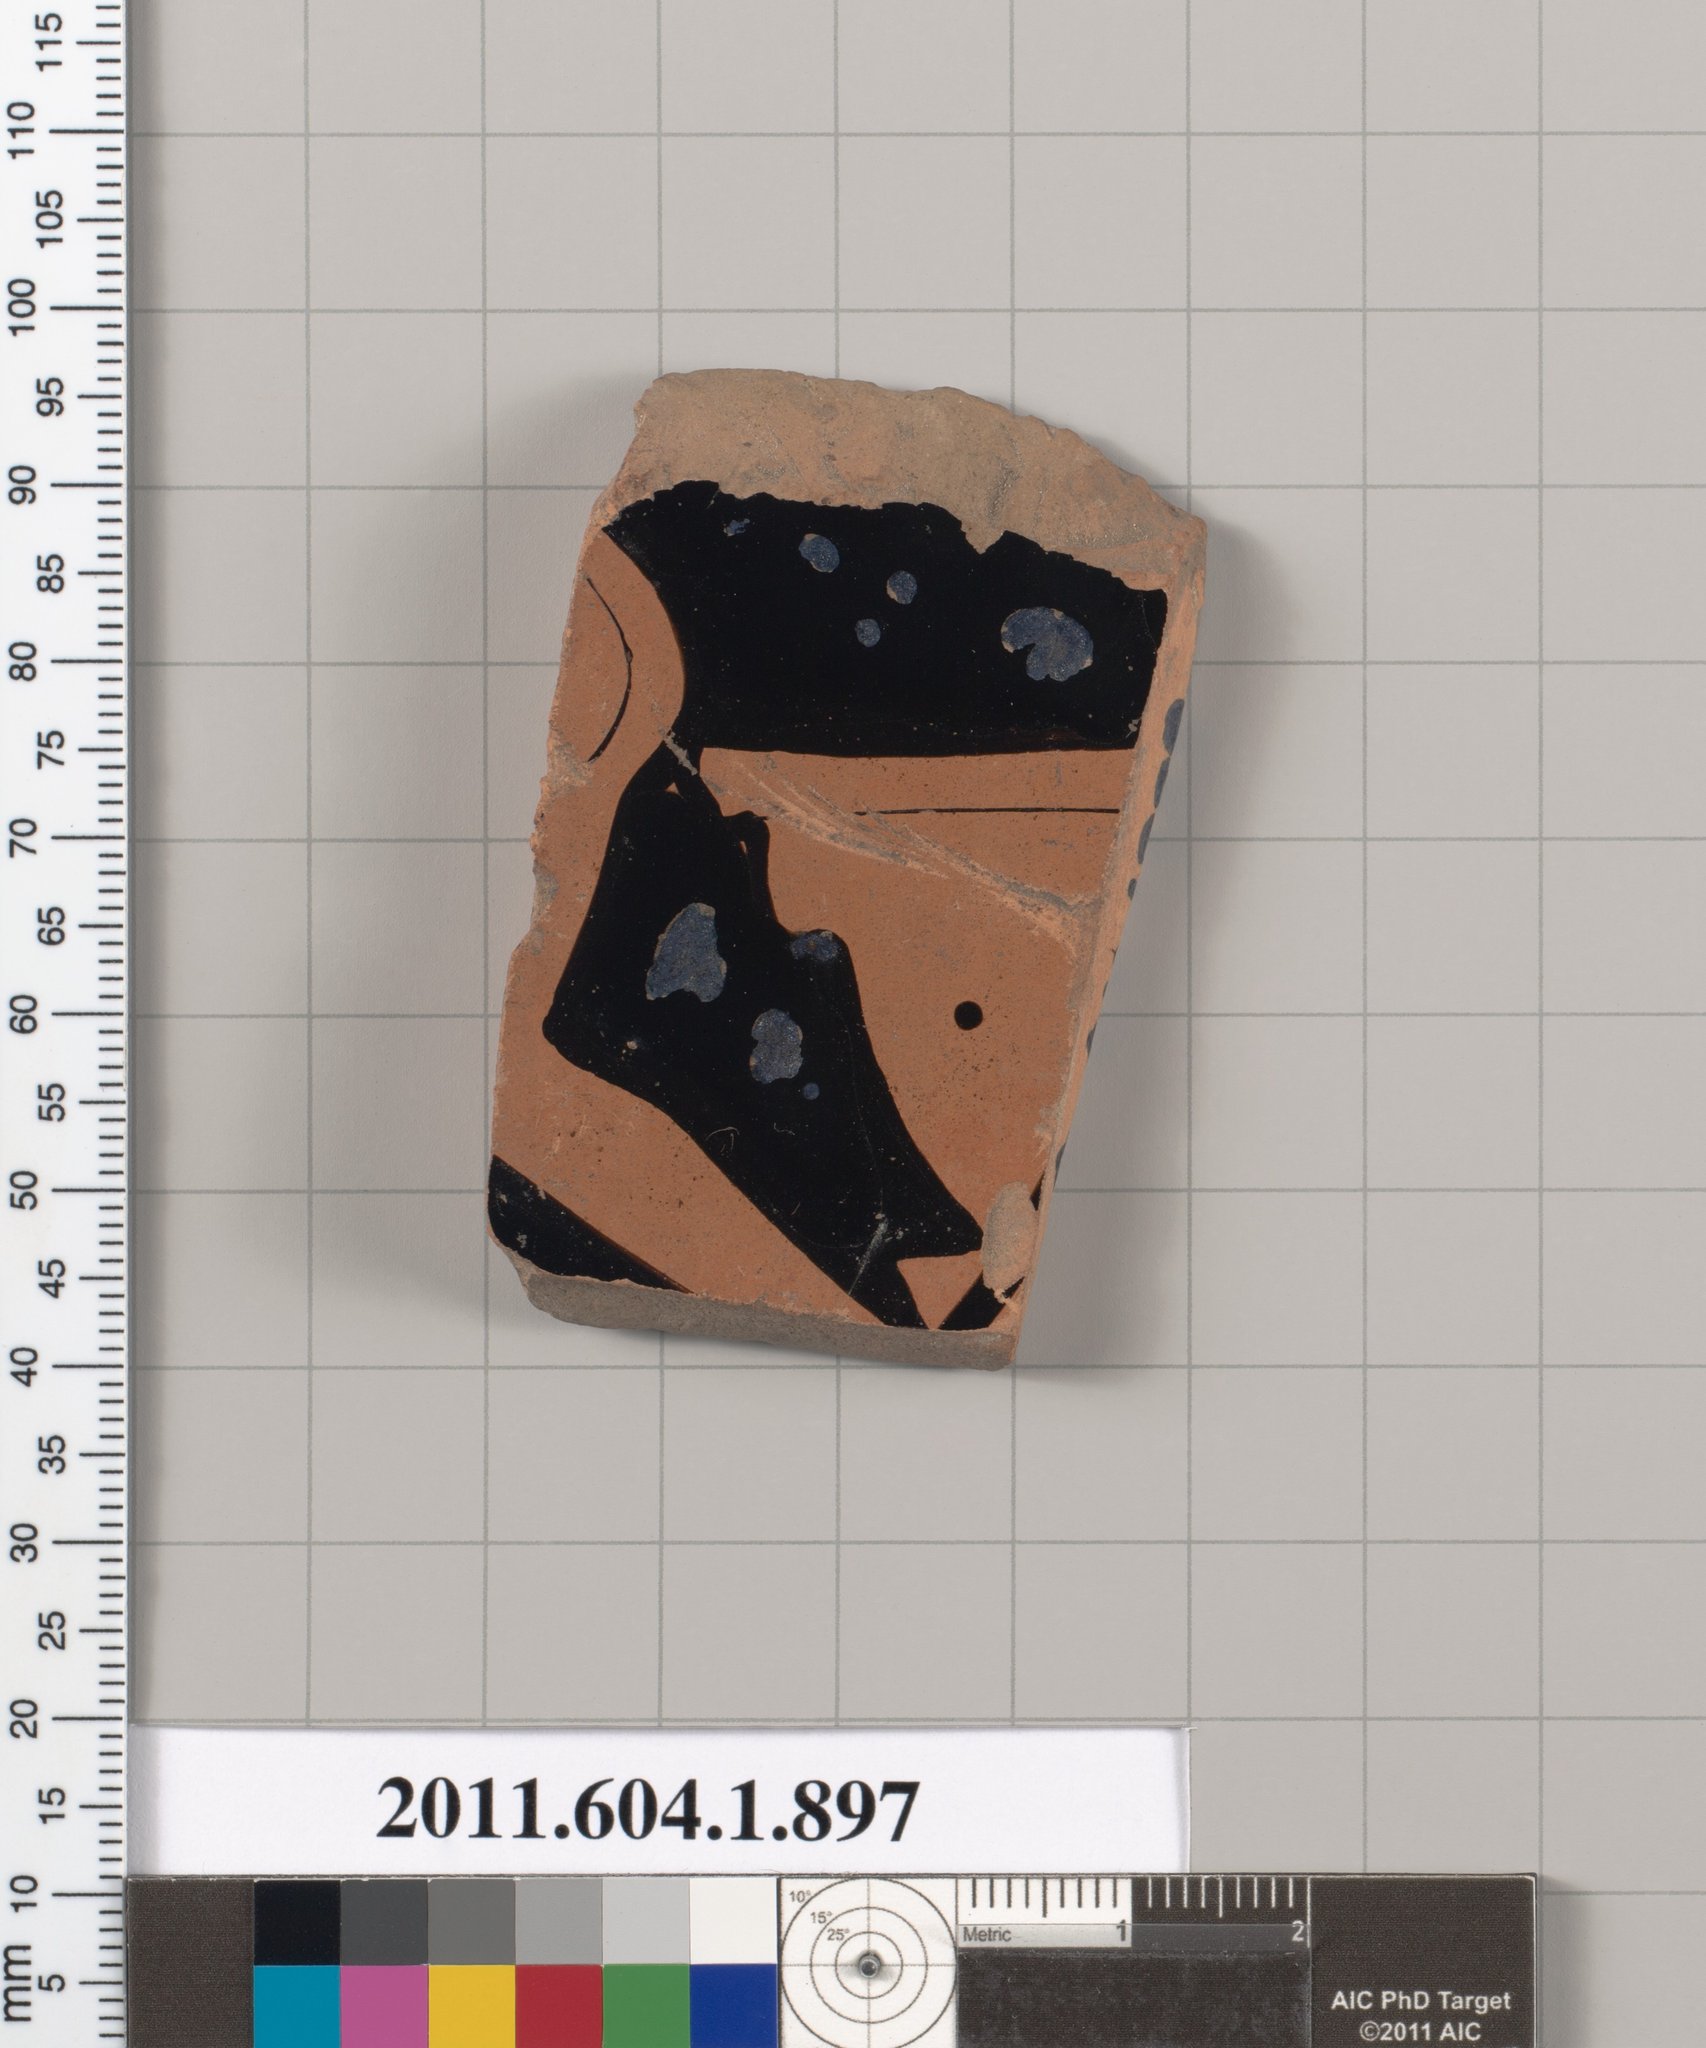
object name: kylix fragment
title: Terracotta fragment of a kylix (drinking cup)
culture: greek, attic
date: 500-476 BCE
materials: terracotta